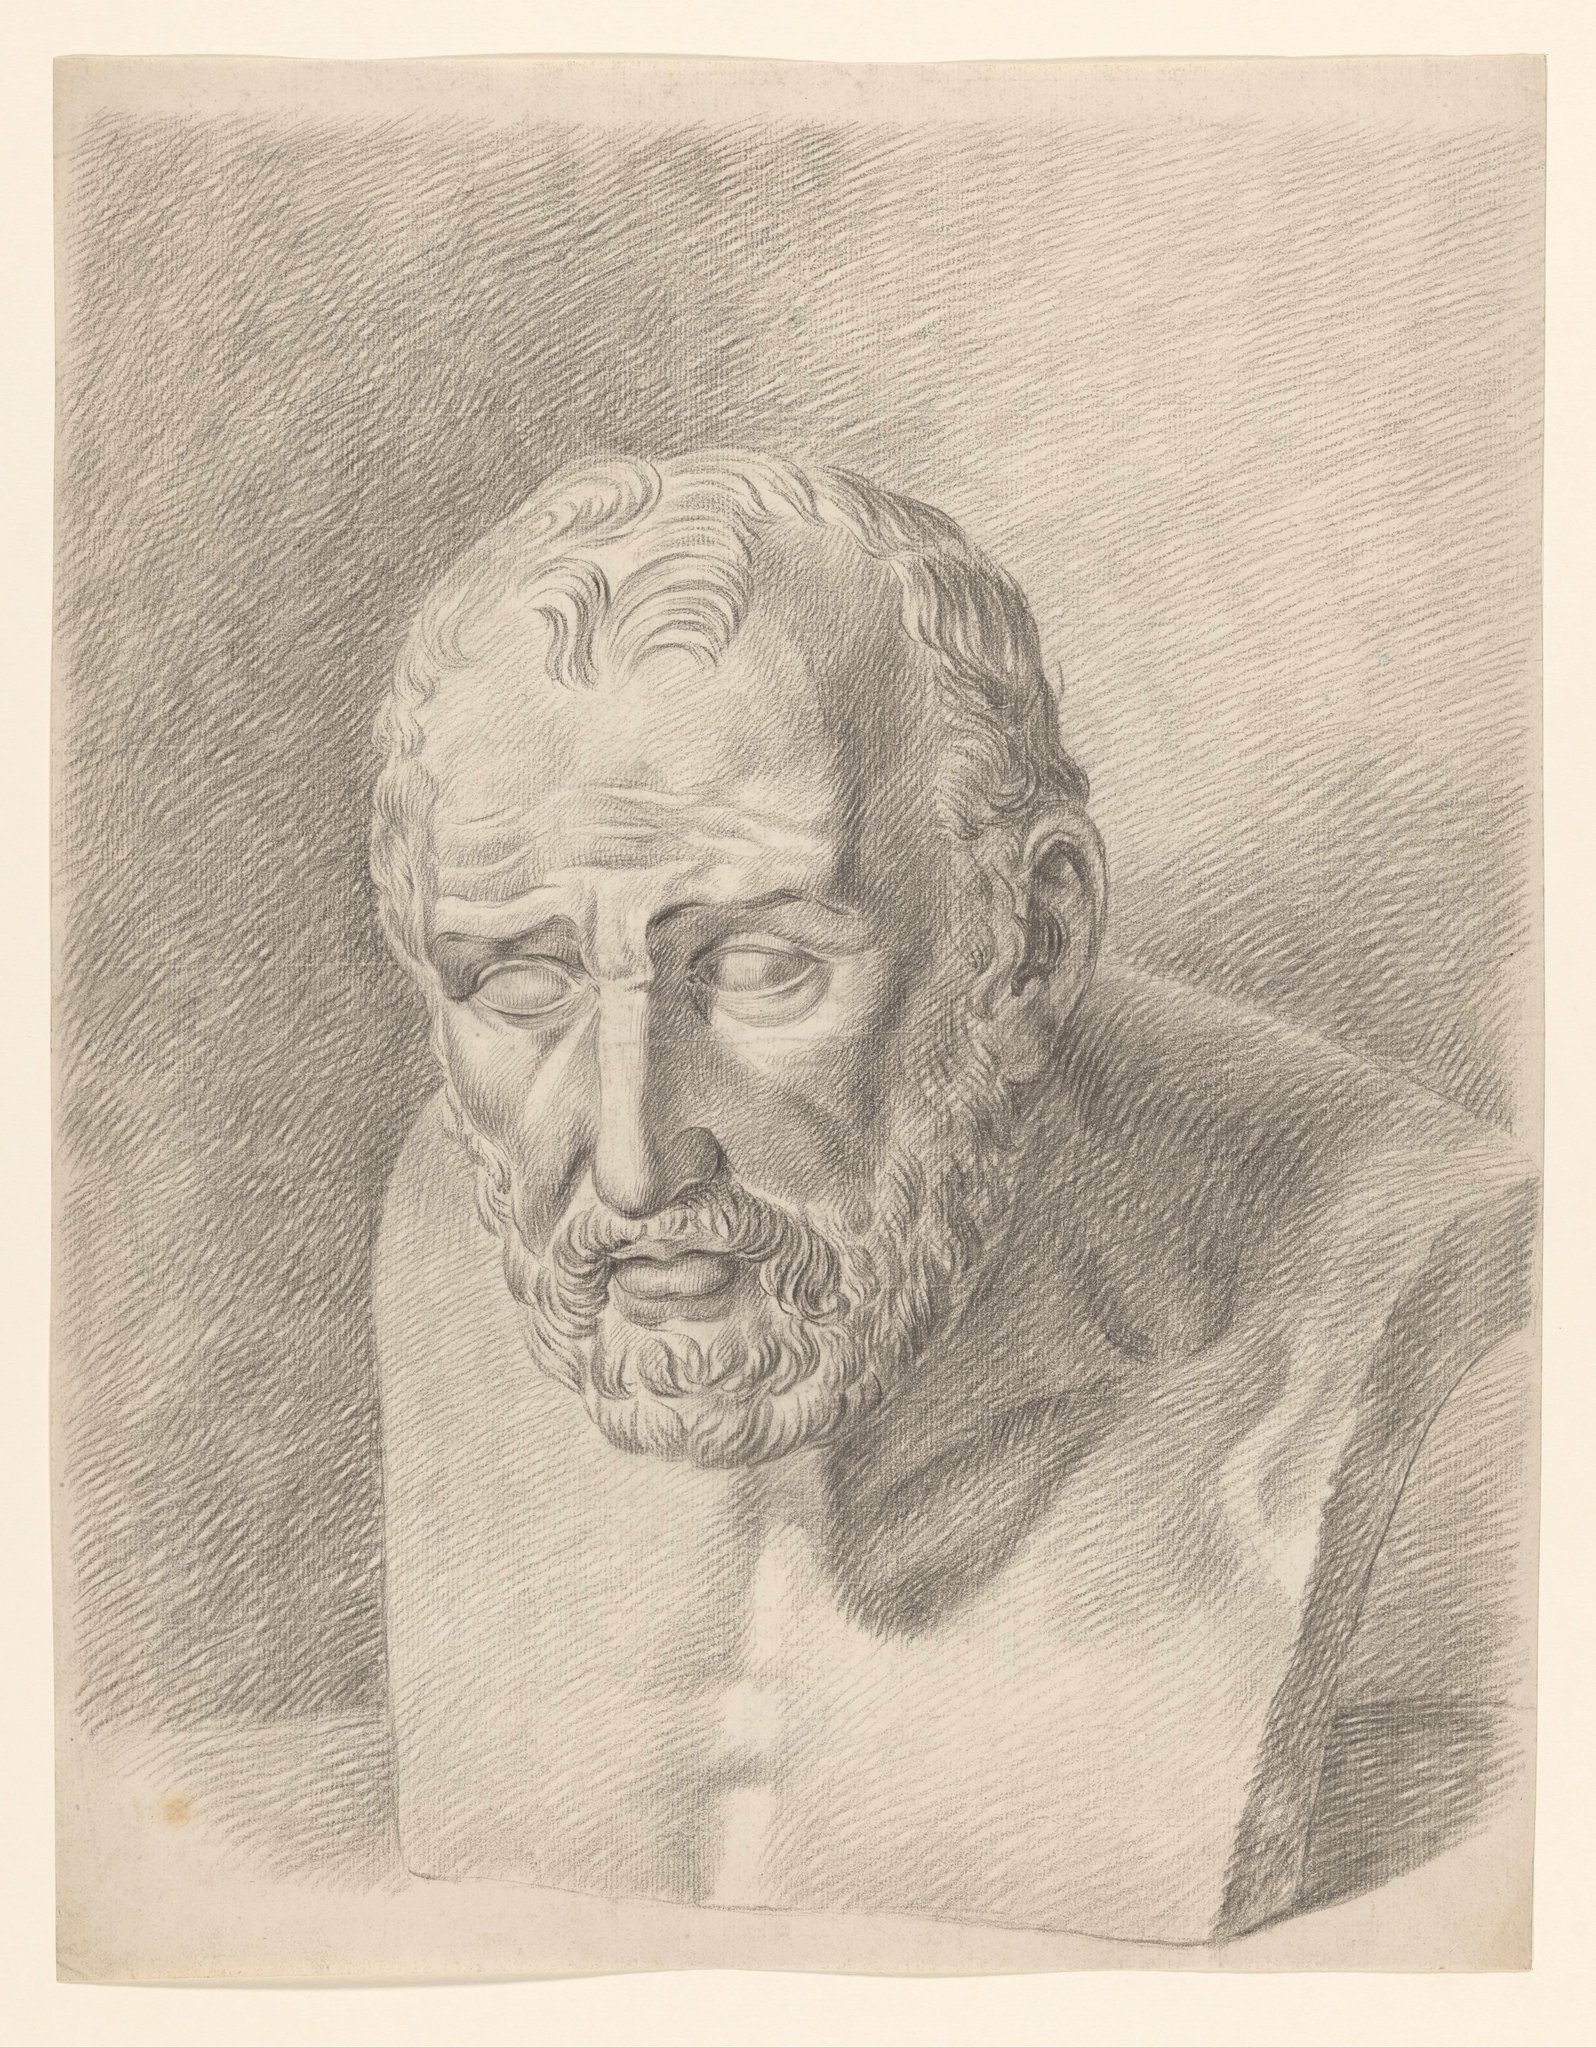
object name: drawing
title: Academiestudie naar gips van antieke buste van een man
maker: johannes tavenraat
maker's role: draughtsman, painter, print maker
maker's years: 1809-1881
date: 1819-1881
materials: chalk, paper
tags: piece of sculpture, reproduction of a piece of sculpture (+ ceramics ~ arts)